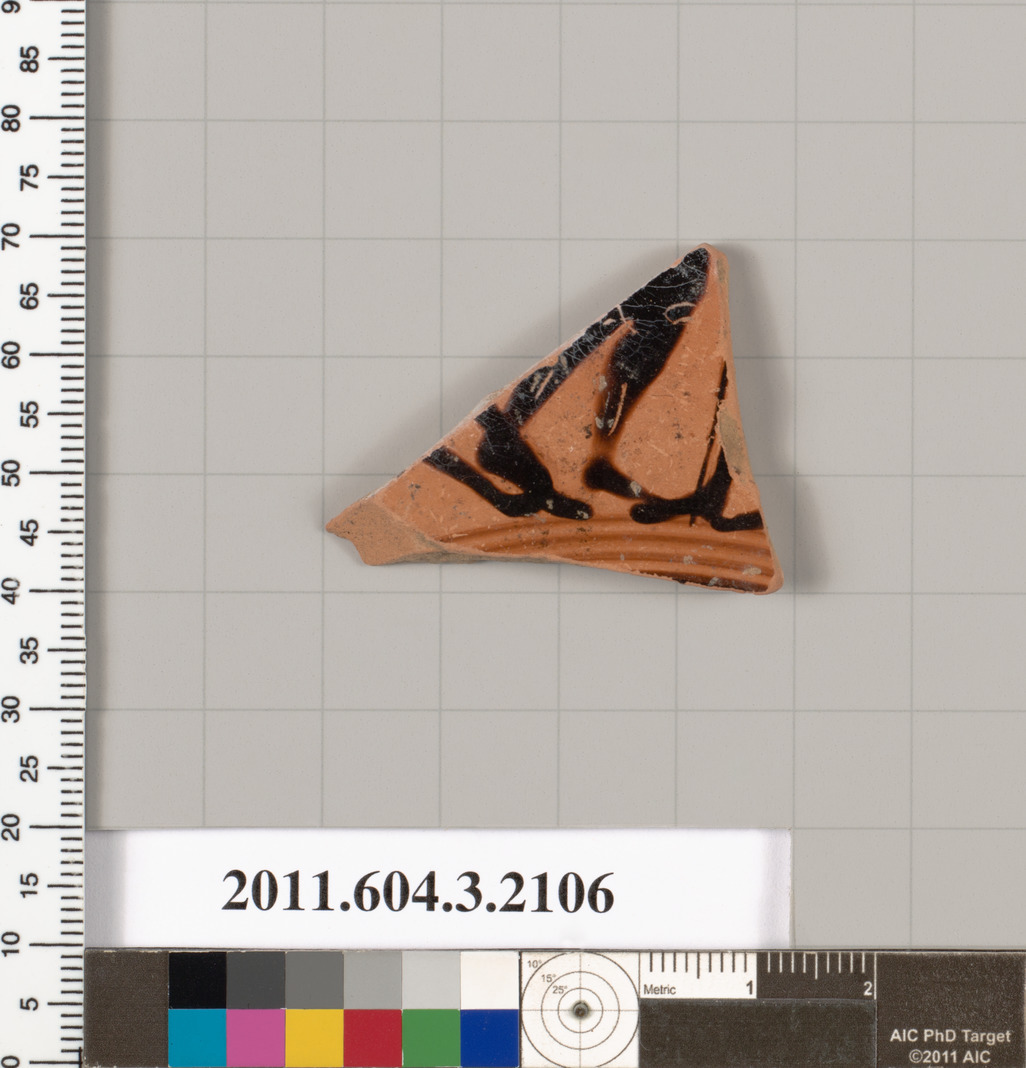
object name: kylix fragment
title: Terracotta fragment of a kylix (drinking cup)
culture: greek, attic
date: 500-480 BCE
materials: terracotta